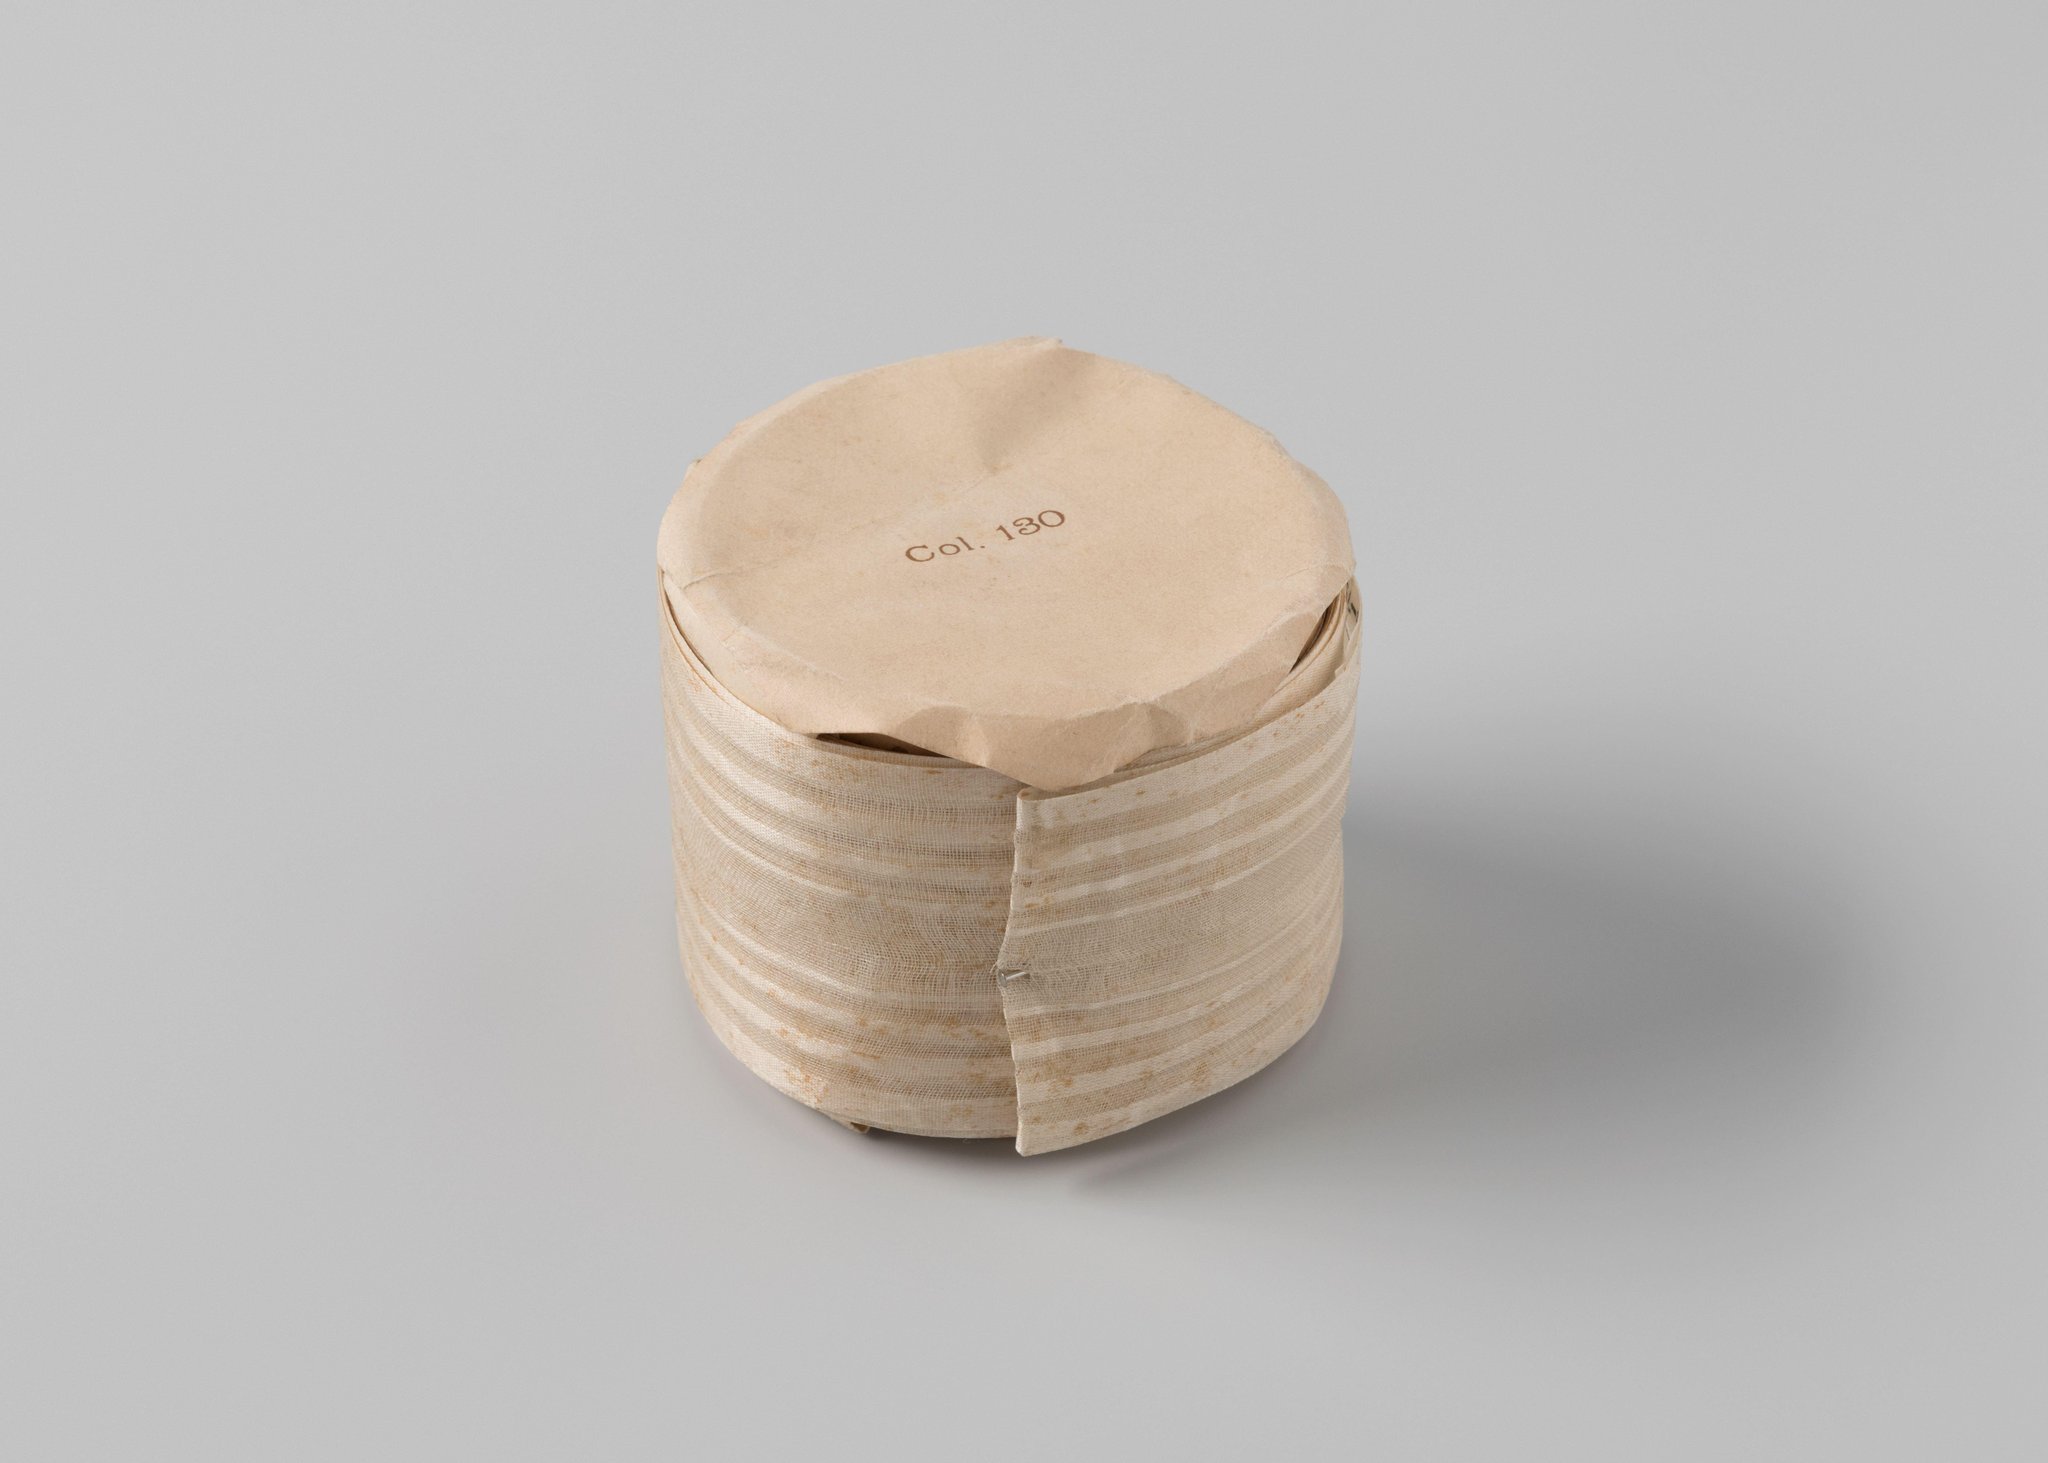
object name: ribbon material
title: Lint van crèmekleurig gaas met streepmotief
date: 1900-1915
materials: textile, silk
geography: nijmegen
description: Lint van crèmekleurig gaas met streepmotief.